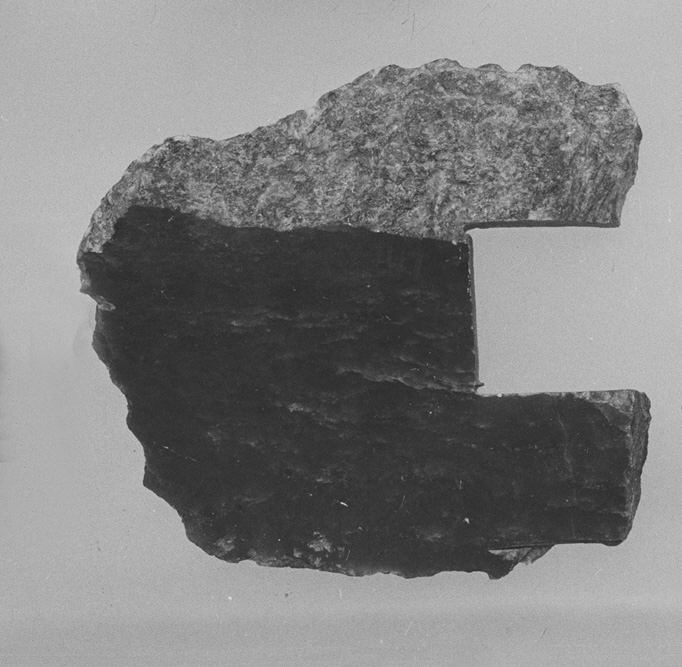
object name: fragment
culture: german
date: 1902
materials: jade